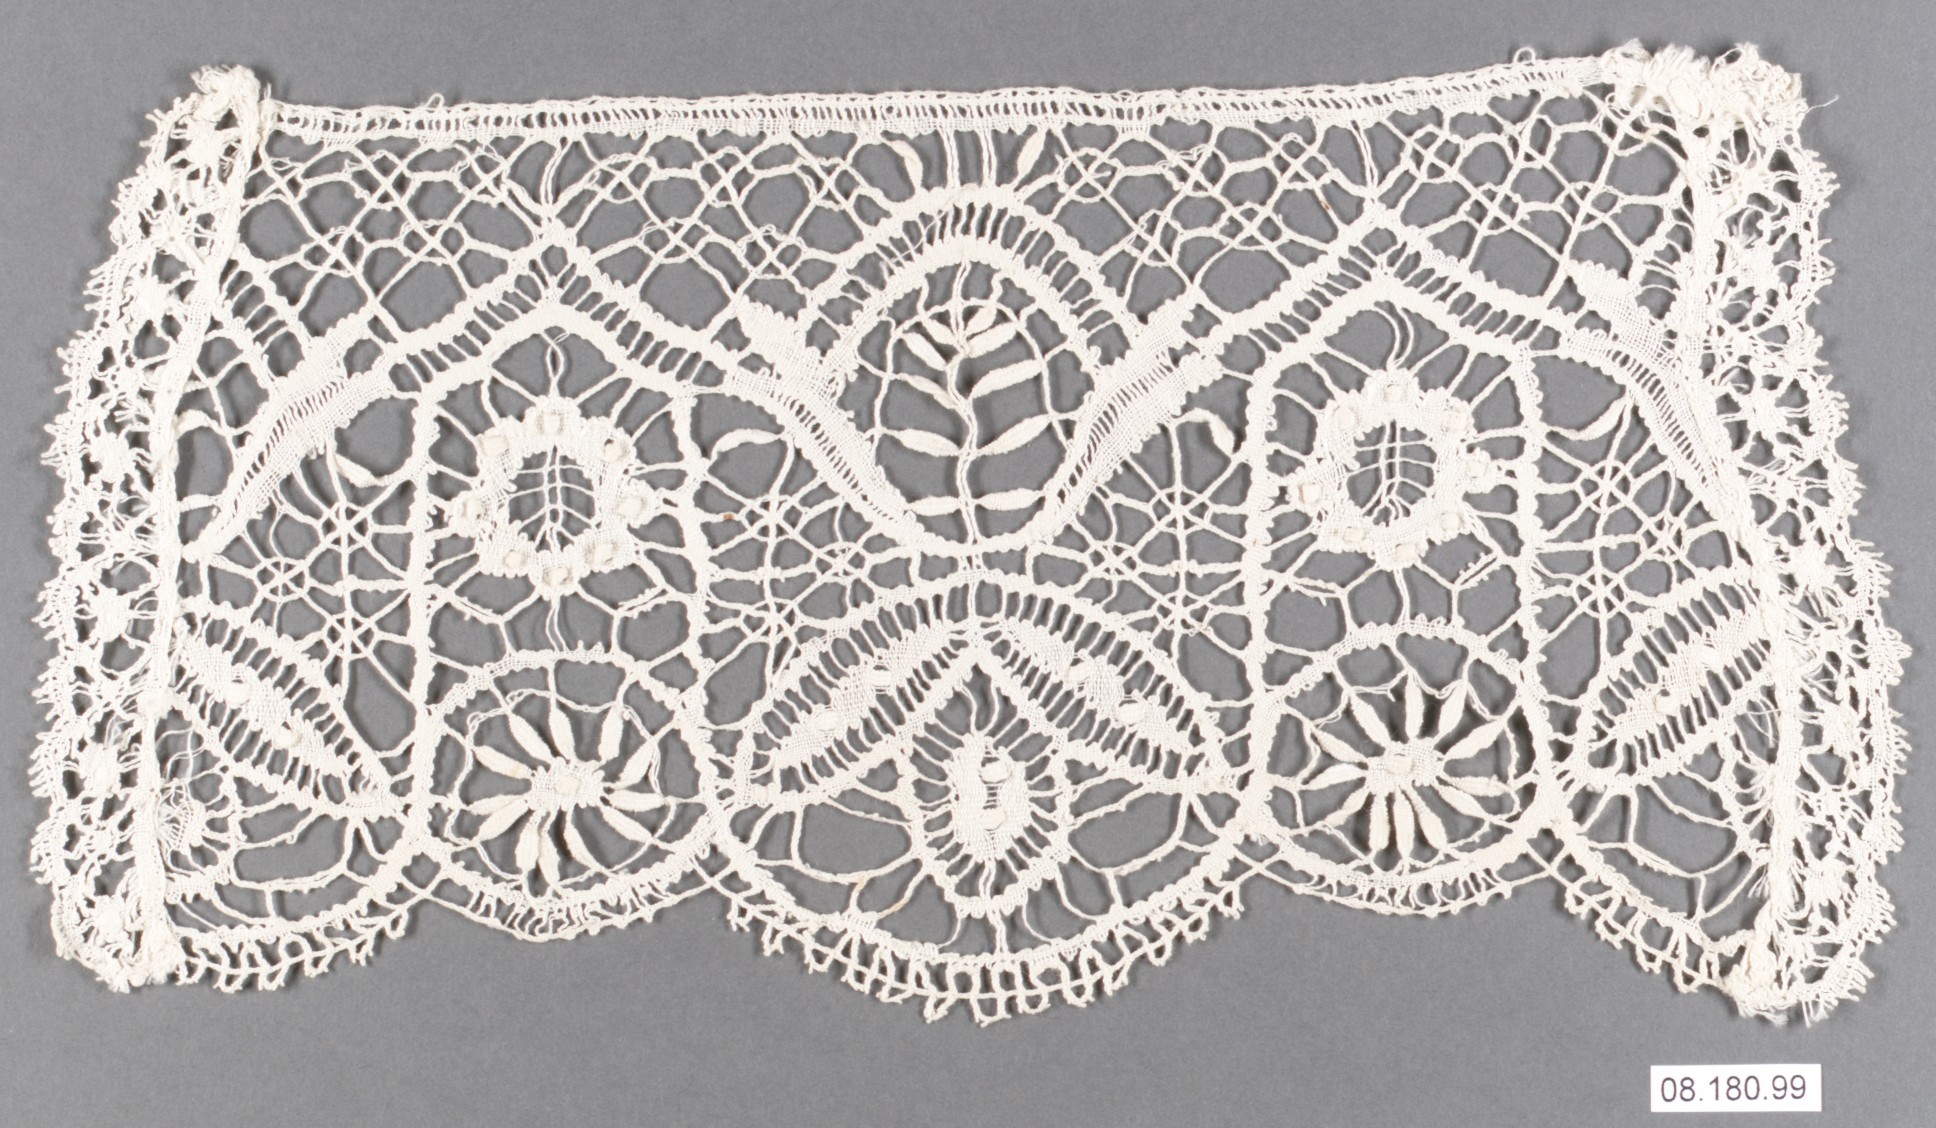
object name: fragment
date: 1801-1900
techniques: lace